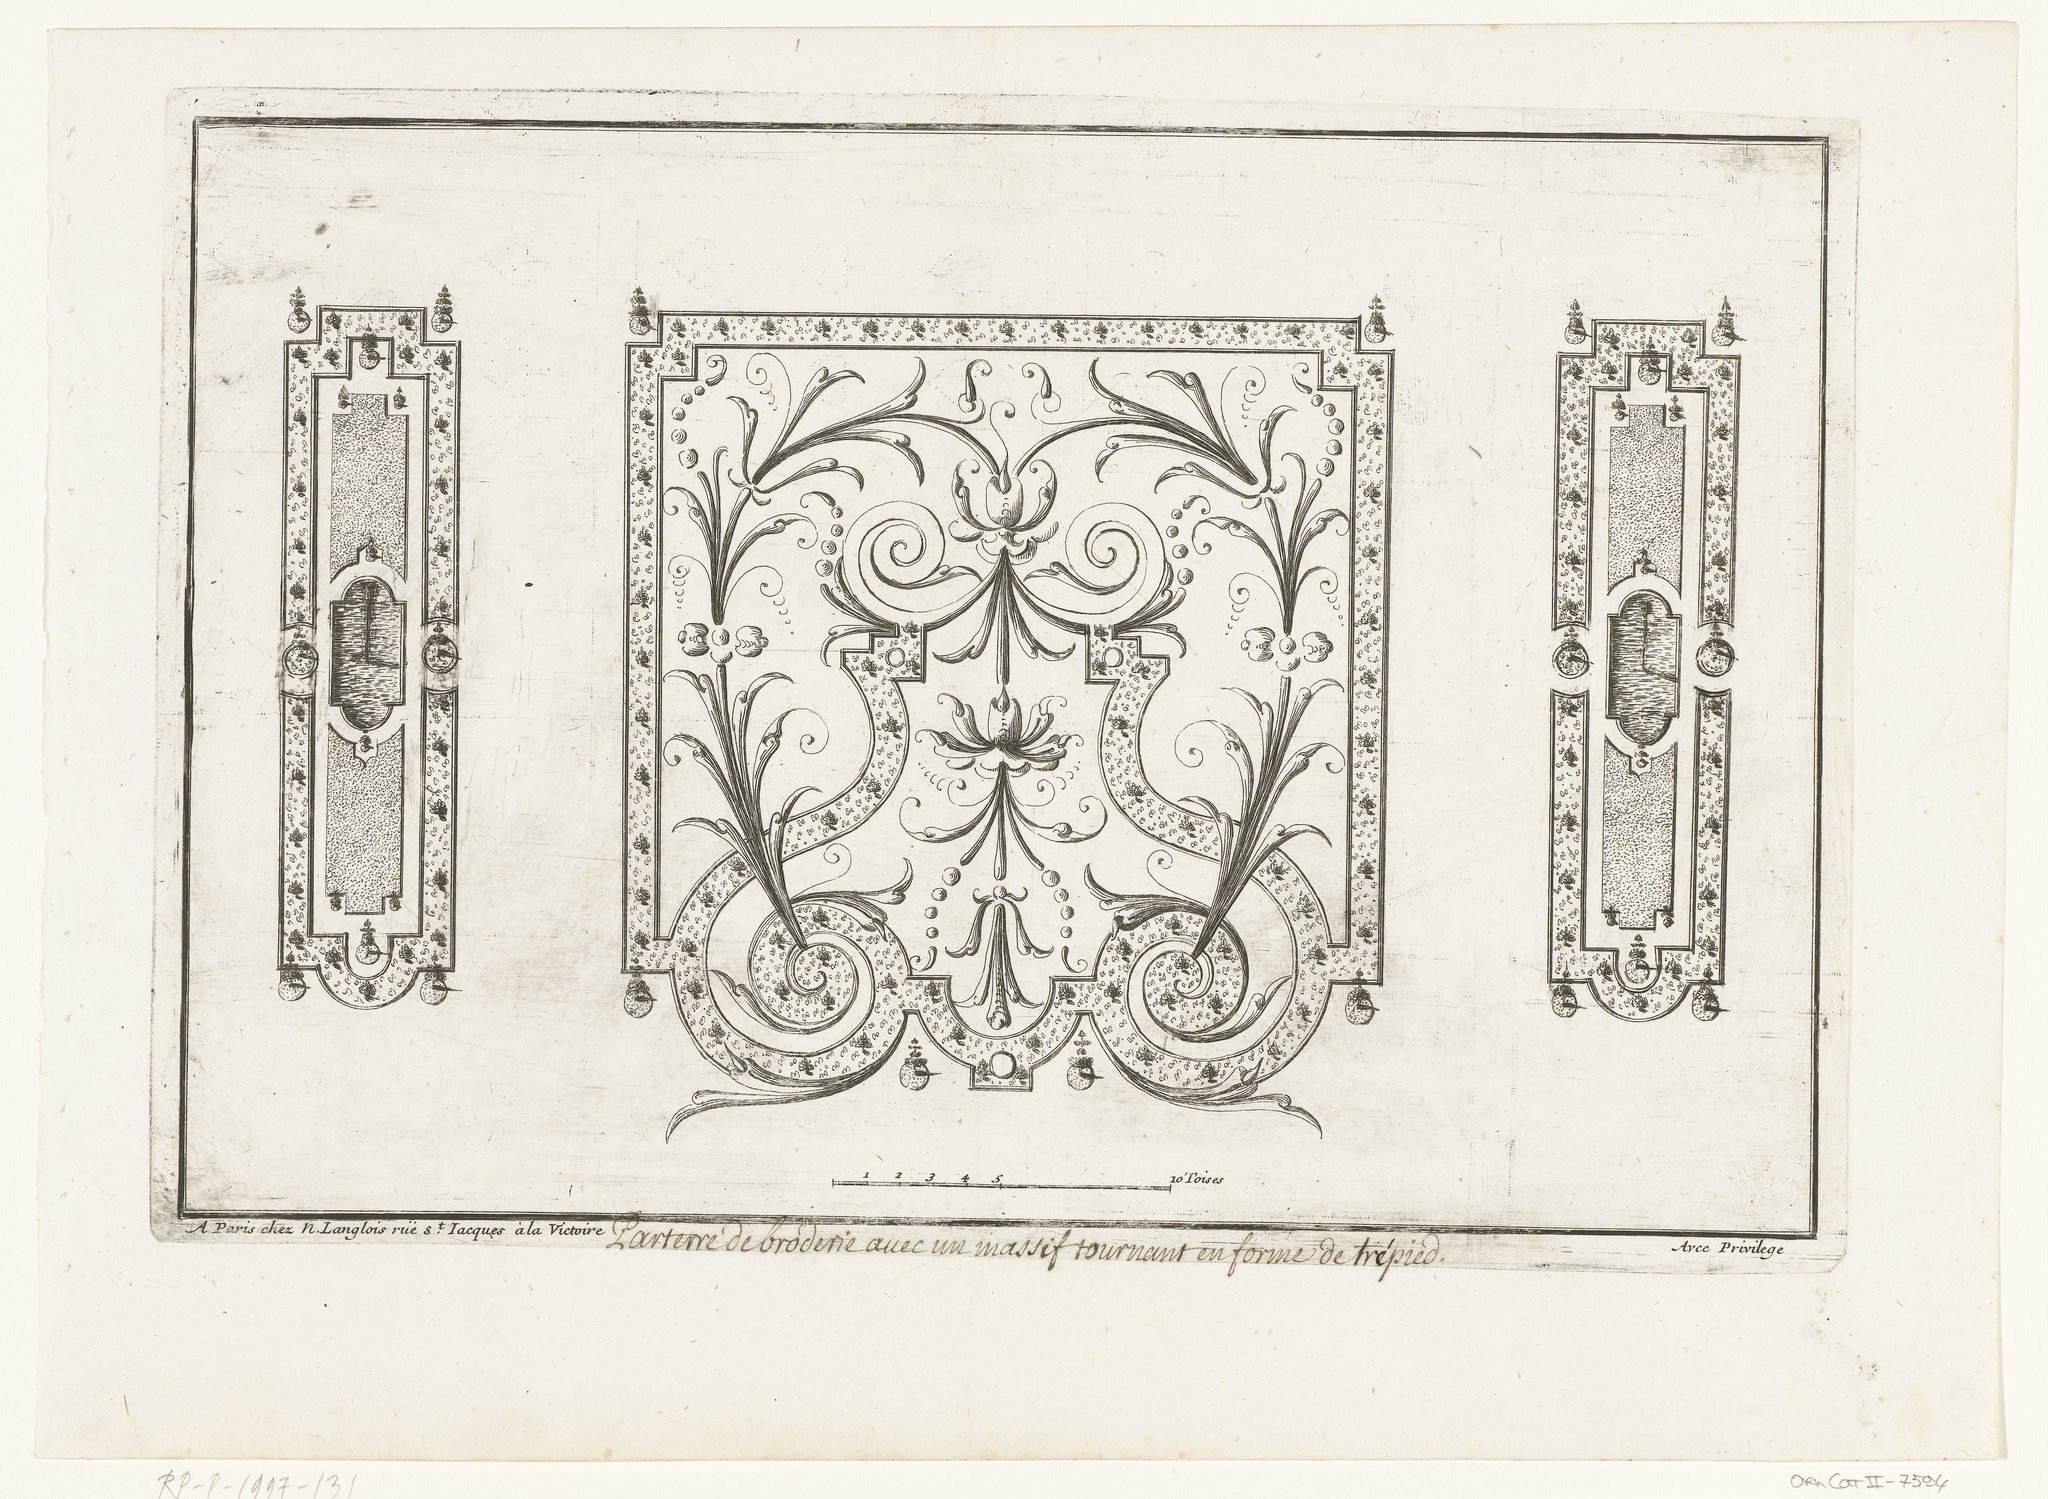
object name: print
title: Tuinen met parterres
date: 1670-1680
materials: paper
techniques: etching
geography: france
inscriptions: title: ‘Parterre de broderie avec un massif tournant en forme de trépied.’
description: Met in het midden een vlak in de vorm van een driepoot. Uit serie van 12 bladen.